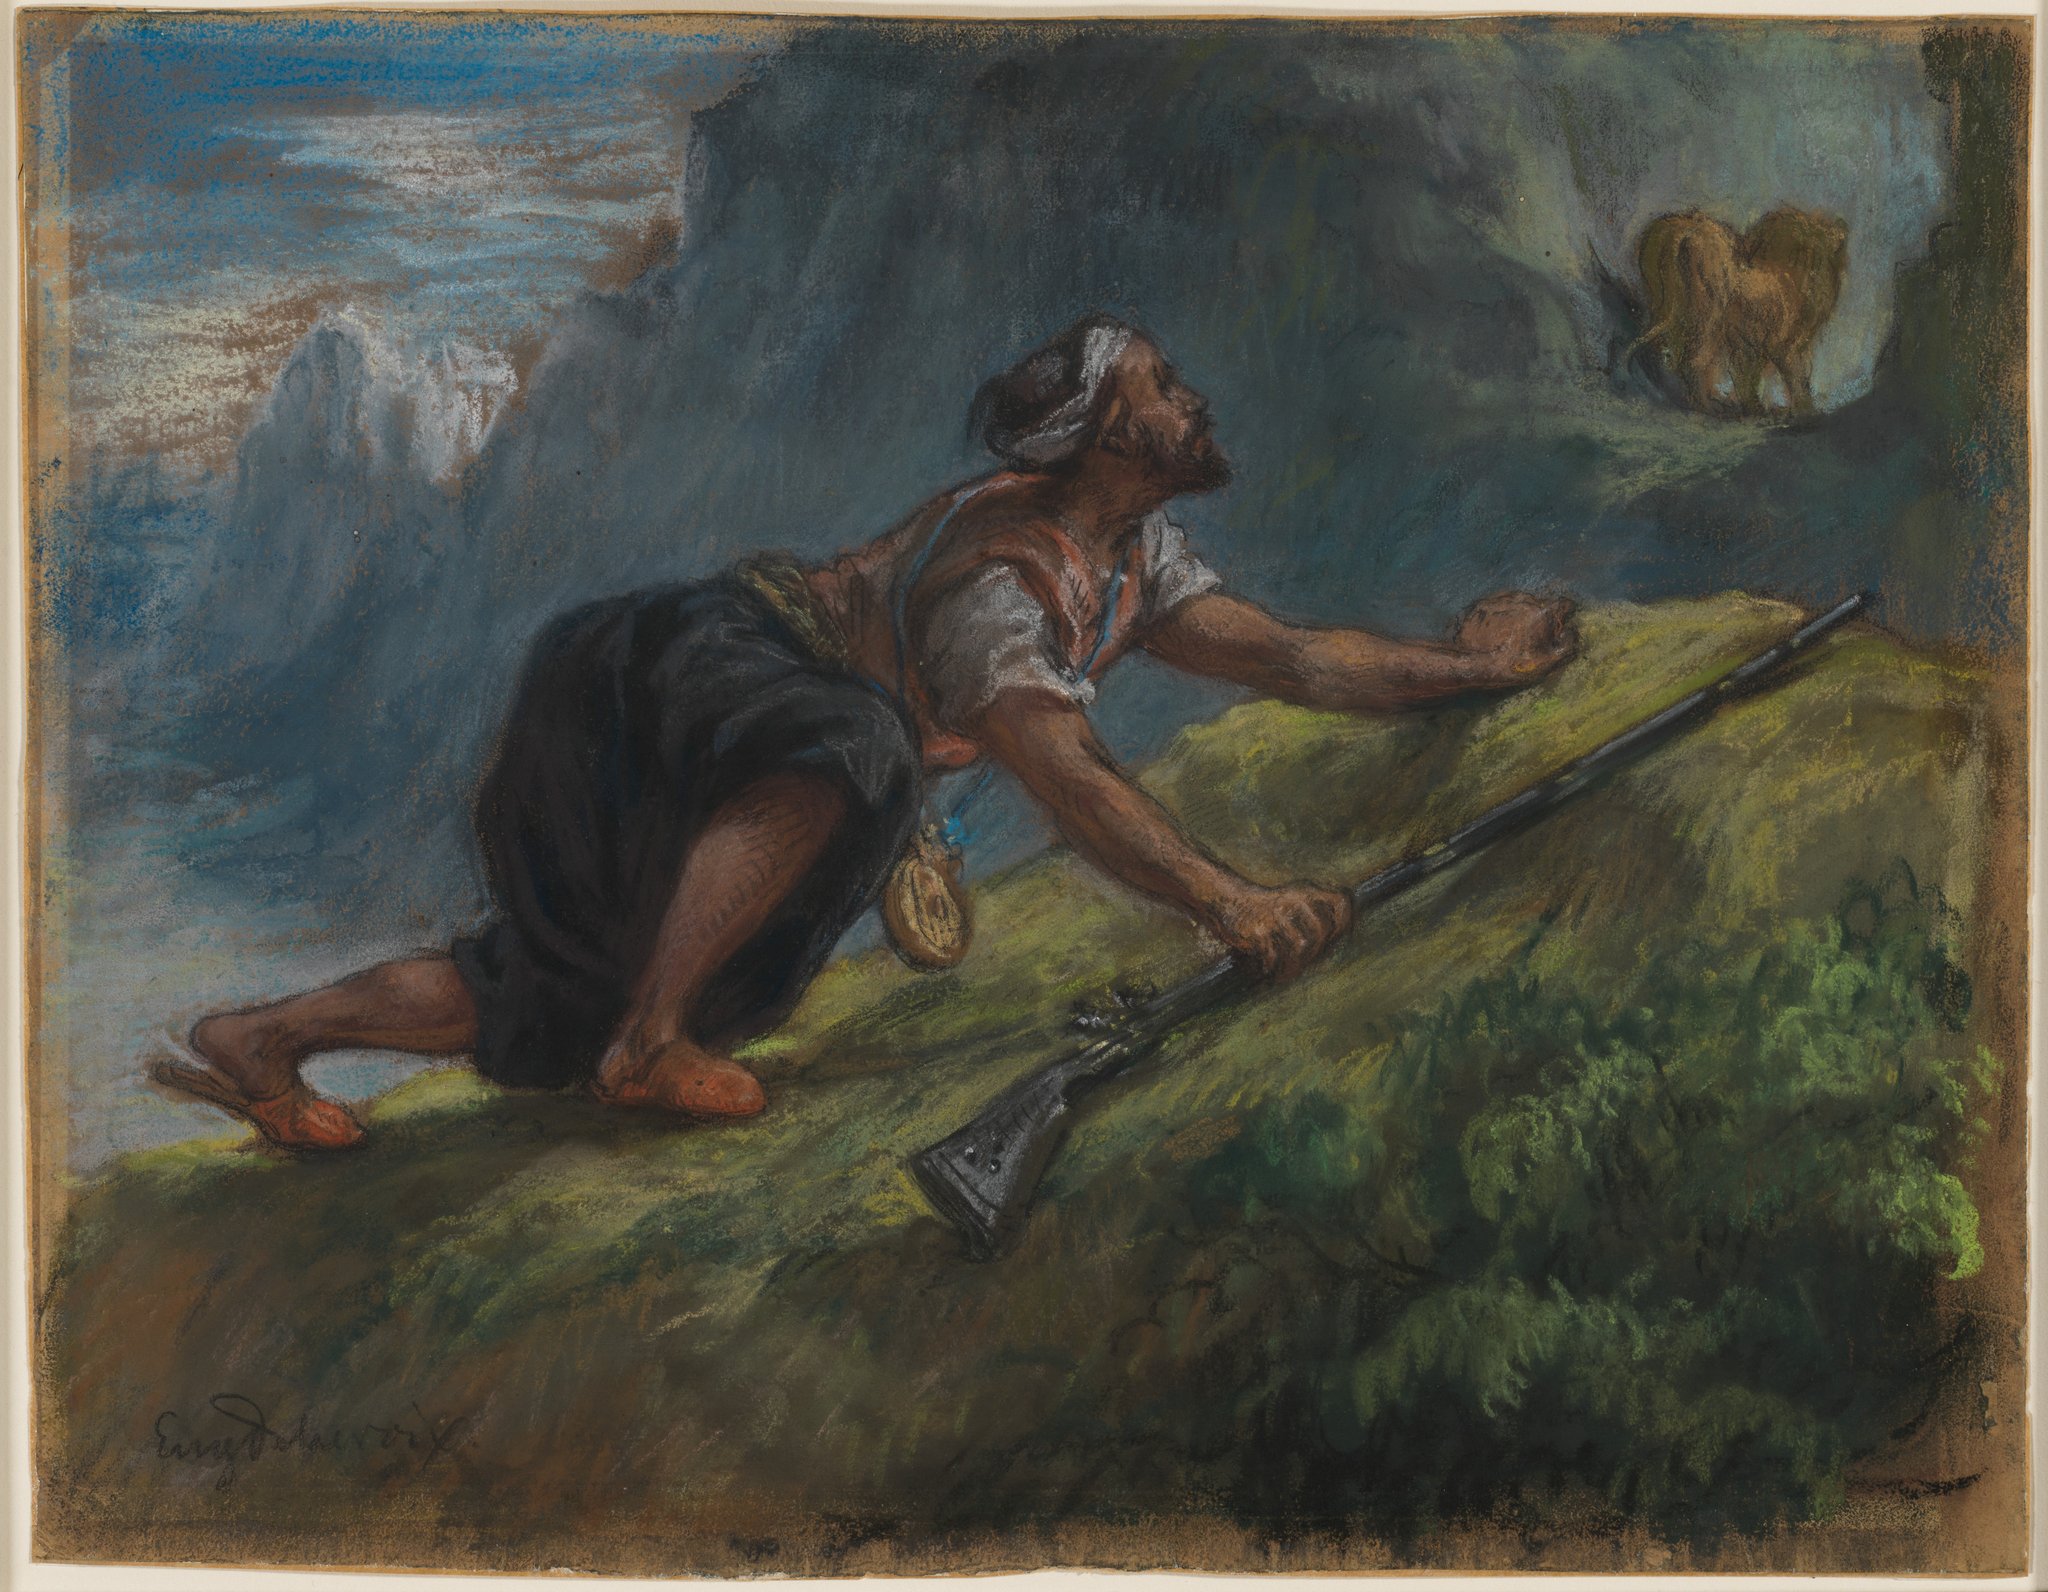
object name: drawing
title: A Hunter Stalking a Lion in the Mountains of North Africa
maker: eugène delacroix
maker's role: artist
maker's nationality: french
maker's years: 1798-1863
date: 1849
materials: charcoal, pastel